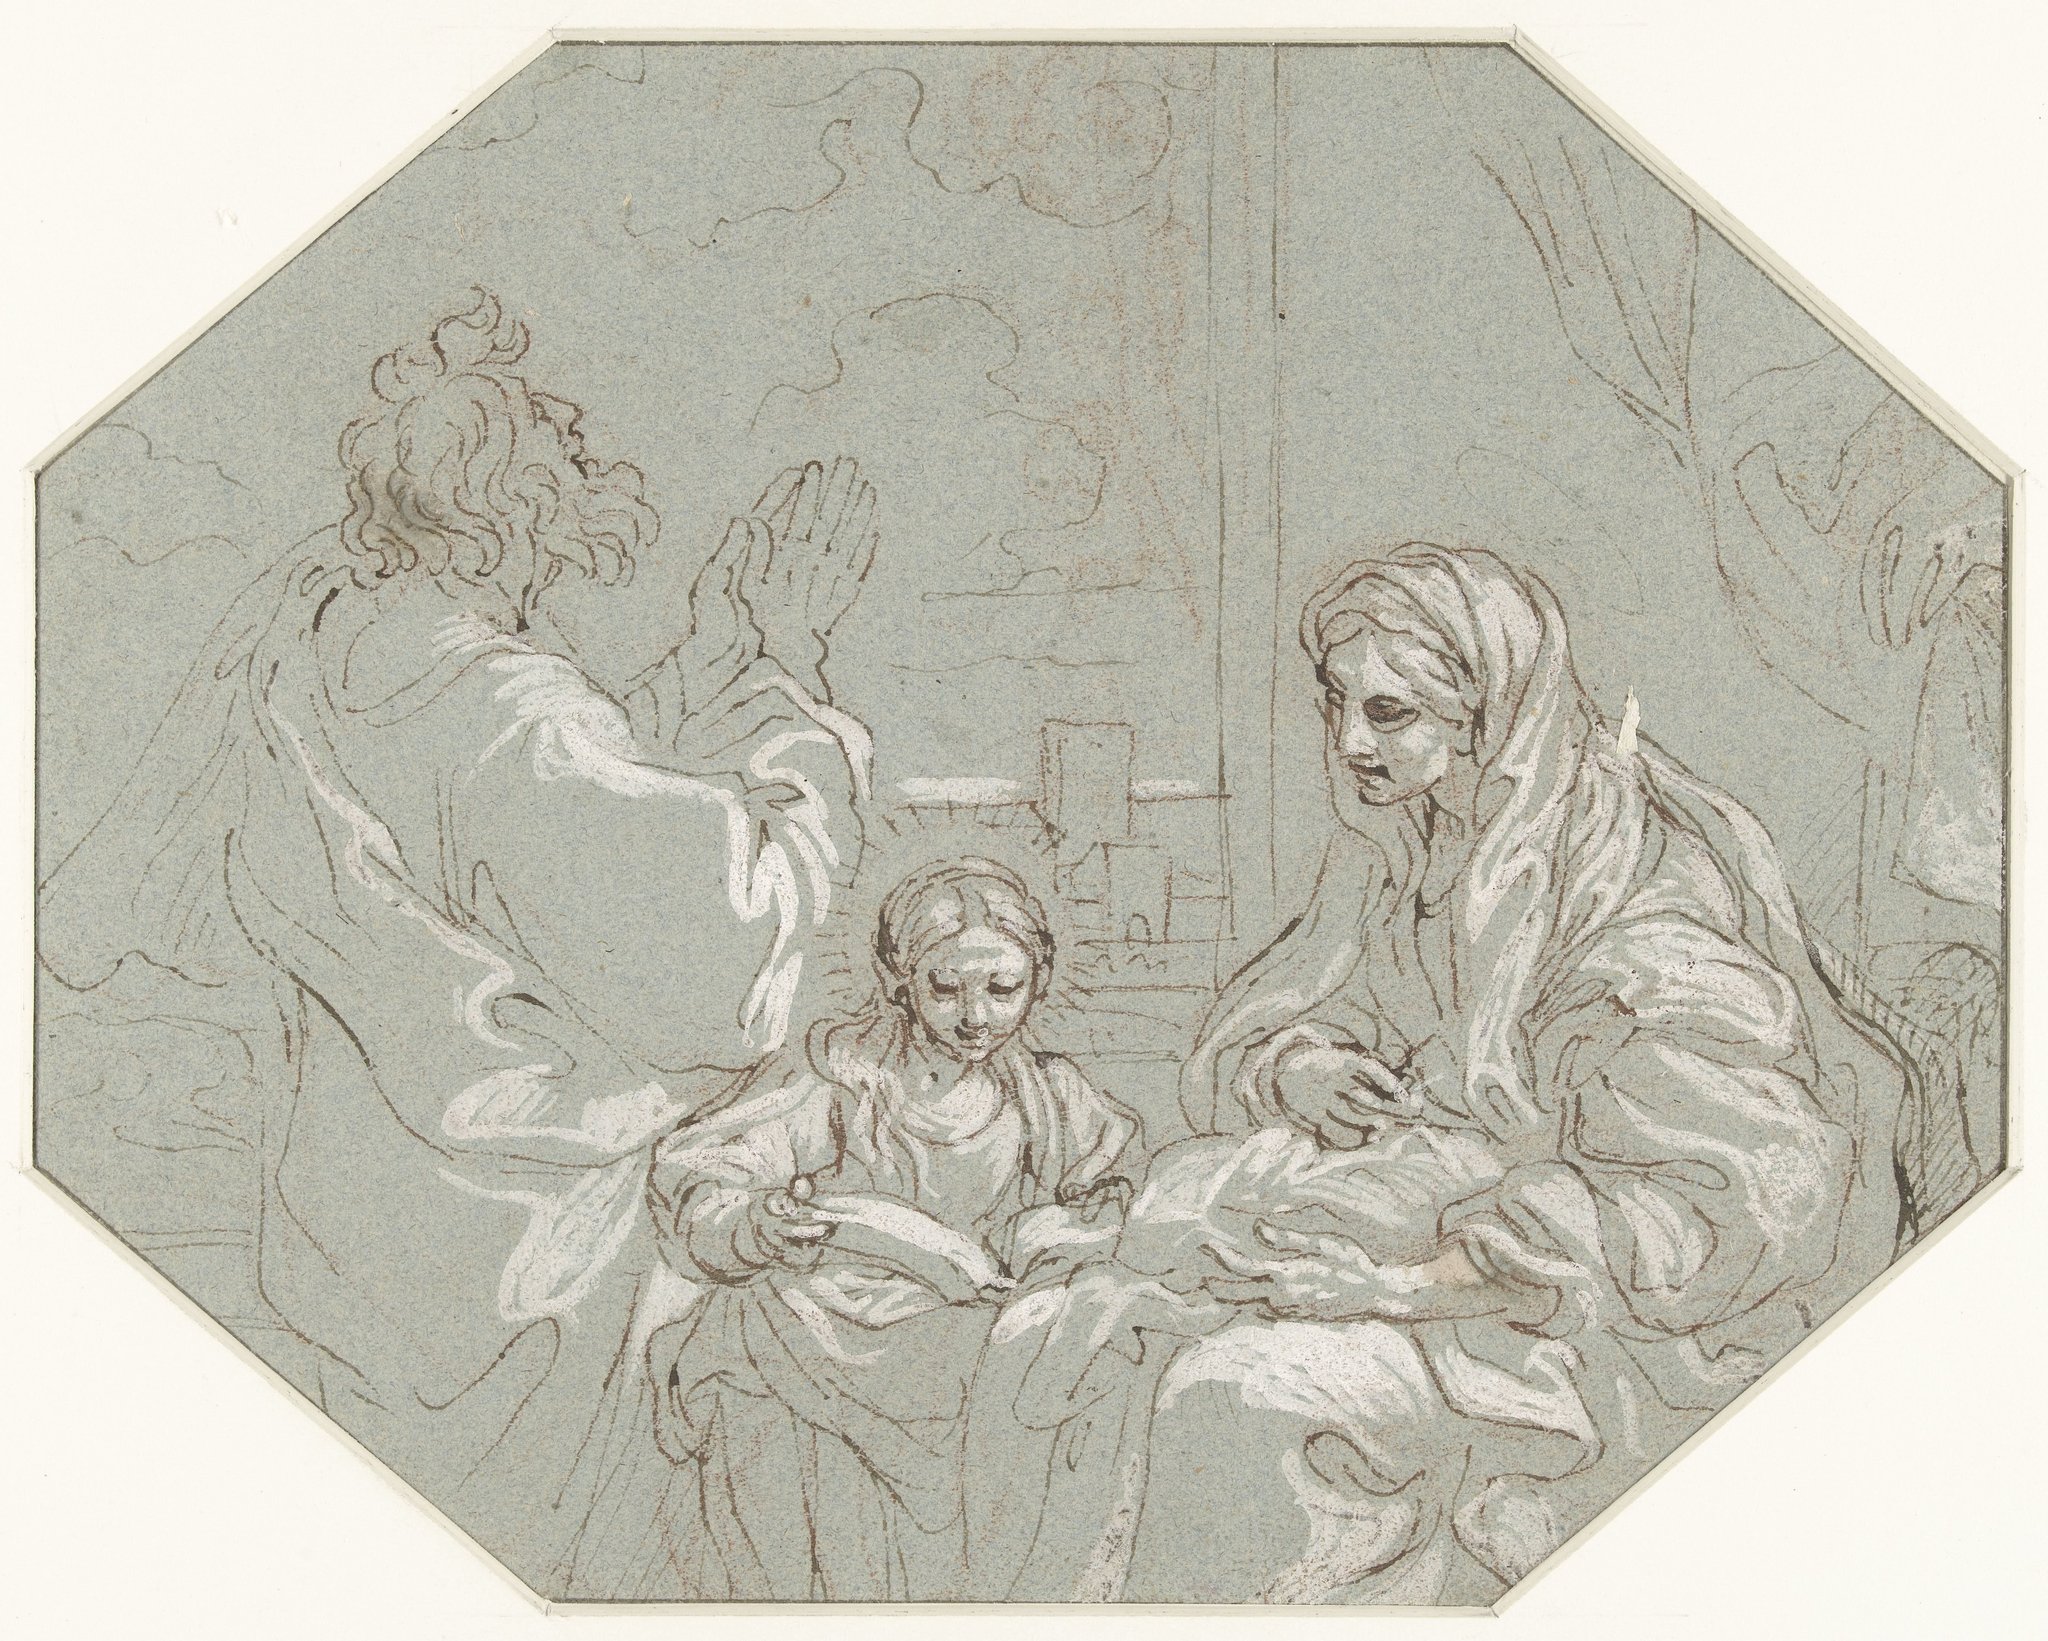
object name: drawing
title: De heilige Anna leert Maria lezen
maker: giacinto calandrucci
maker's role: draughtsman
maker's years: 1646-1707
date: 1656-1707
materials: chalk, paint, ink, paper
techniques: pen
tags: anna teaching mary to read